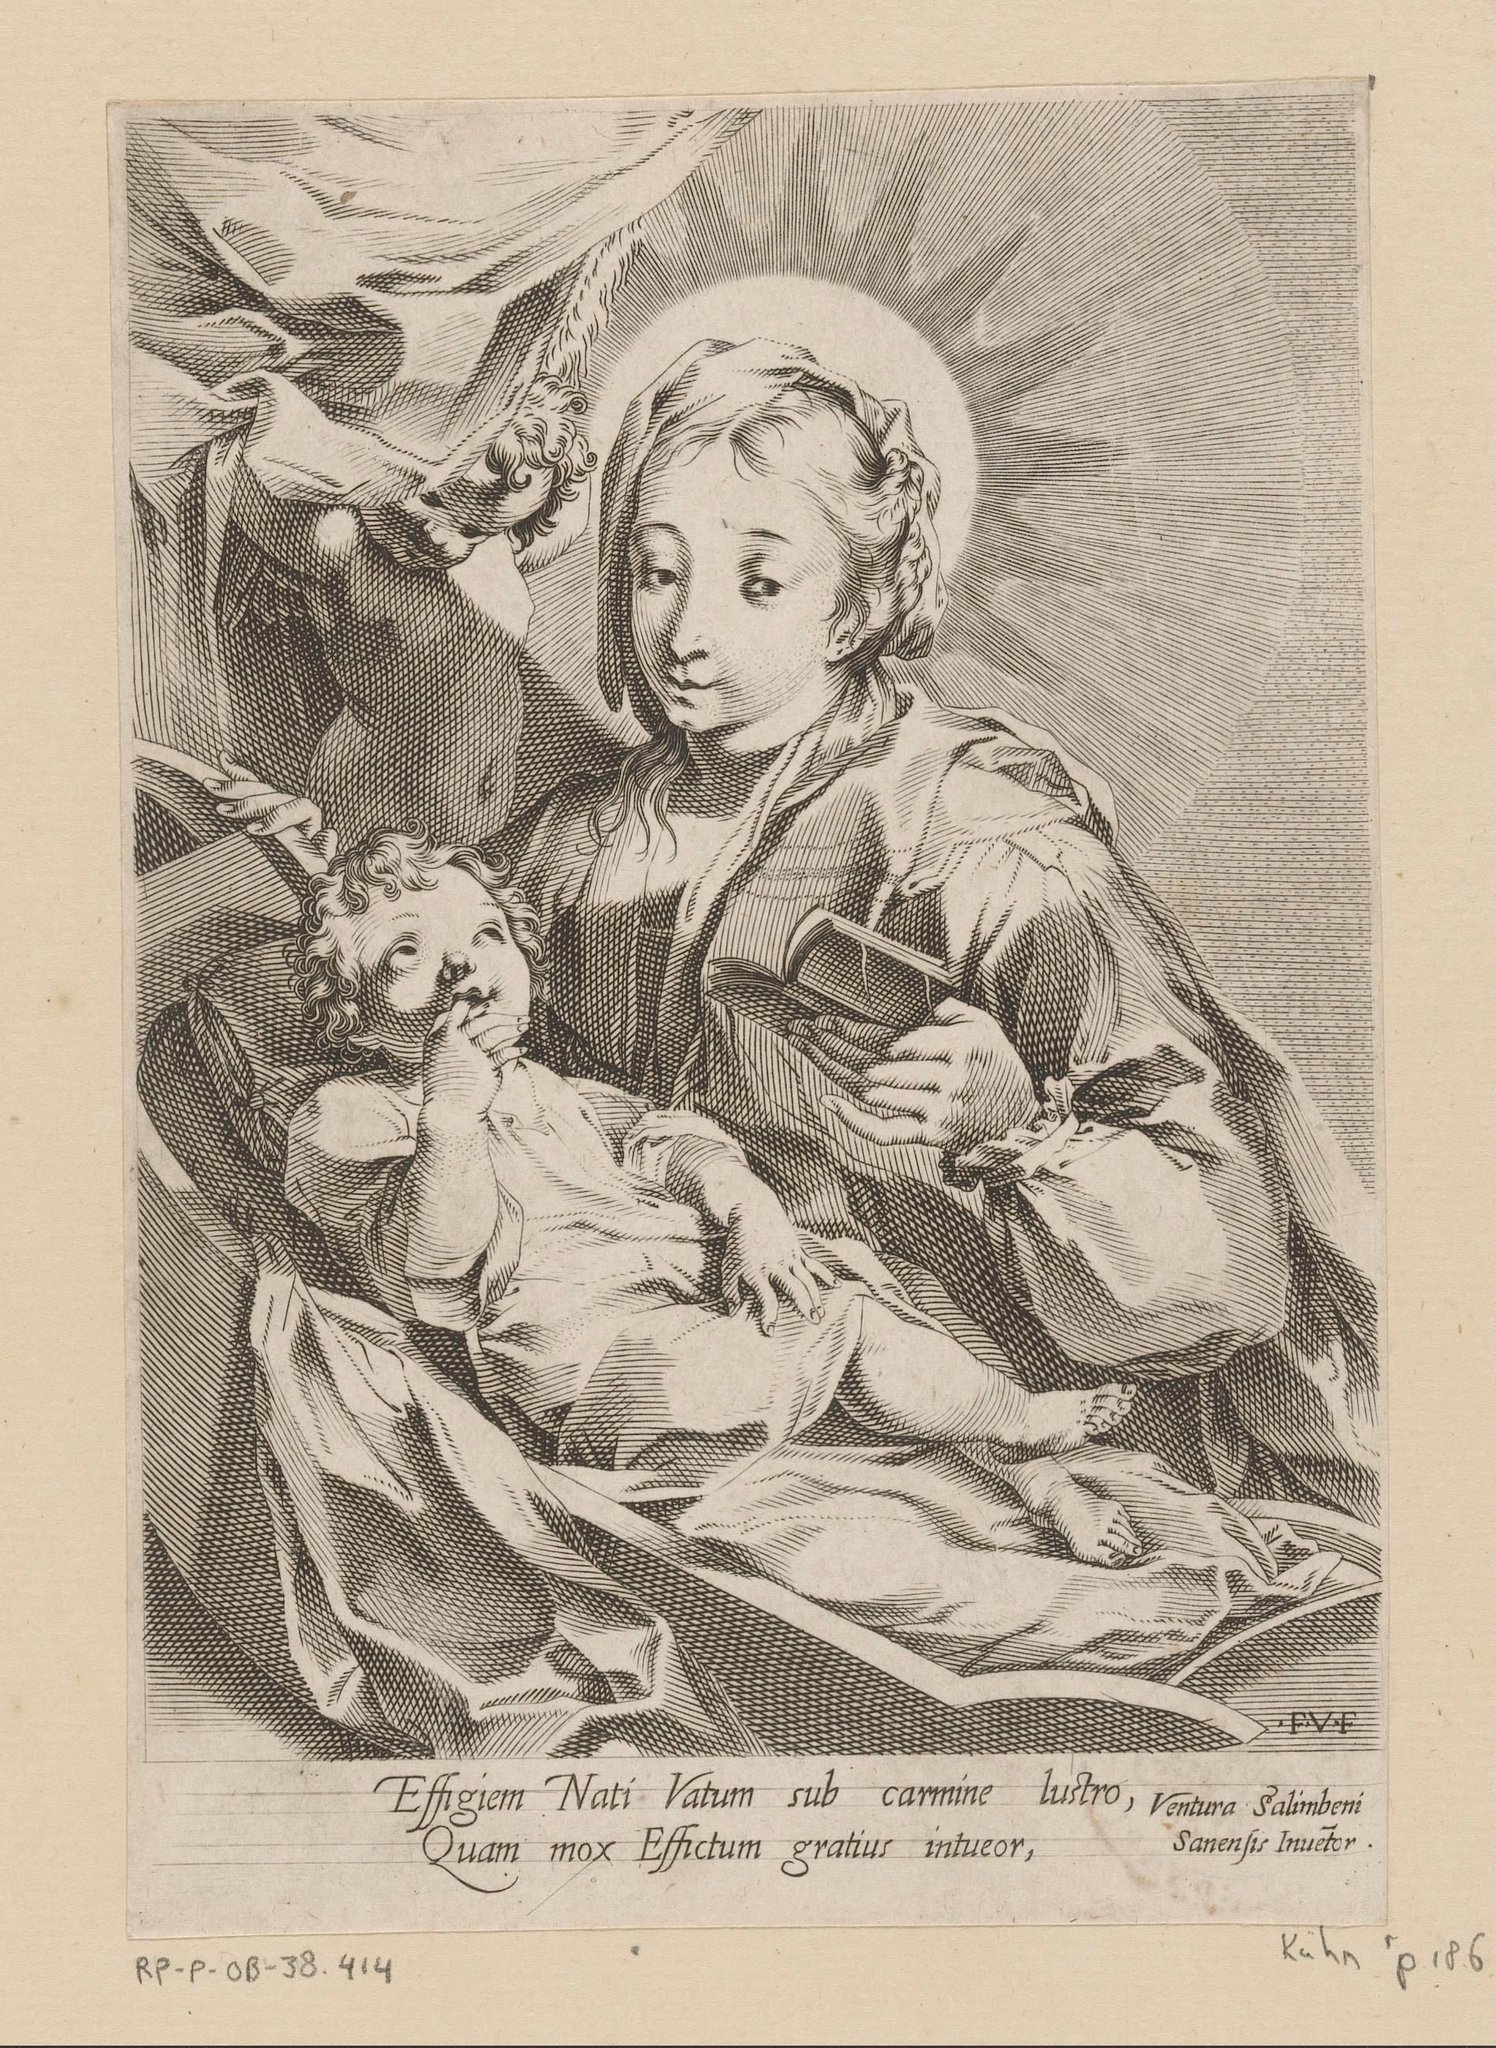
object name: print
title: Maria met Kind in een kribbe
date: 1576-1624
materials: paper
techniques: engraving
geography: italy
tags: madonna: i.e. mary with the christ-child, cradle, crib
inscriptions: collector's mark: Lugt 240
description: Maria met een open boek in de hand. Voor haar ligt het Christuskind in een kribbe. Links houdt een putto een gordijn omhoog. Tweeregelige tekst in het Latijn in de ondermarge.